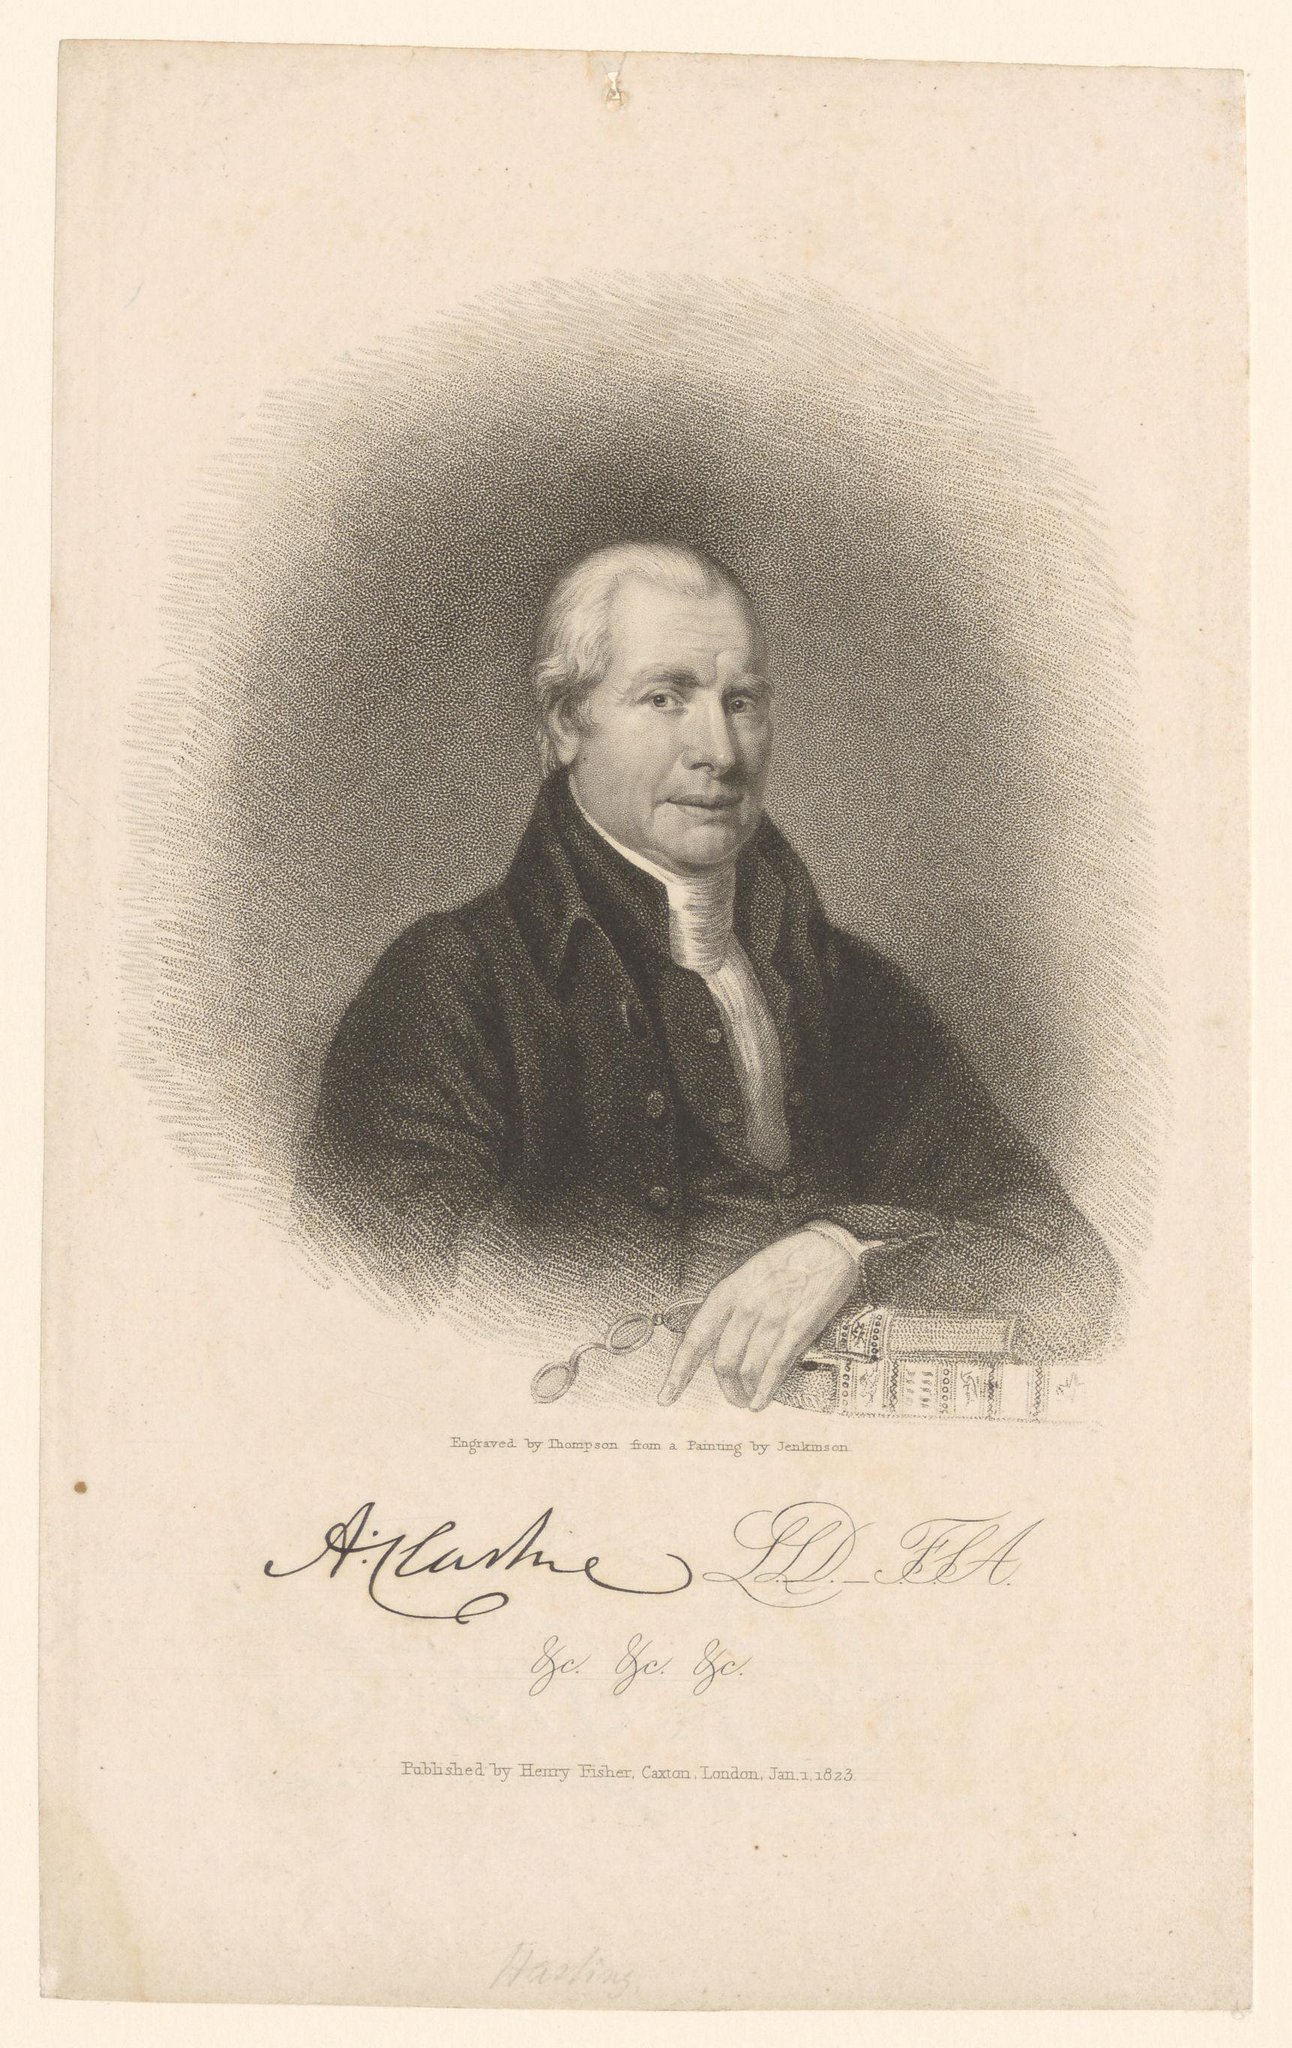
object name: print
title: Portret van Adam Clarke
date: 1801-1823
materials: paper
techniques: roulette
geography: london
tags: theologian, historical persons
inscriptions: collector's mark: Lugt 2228